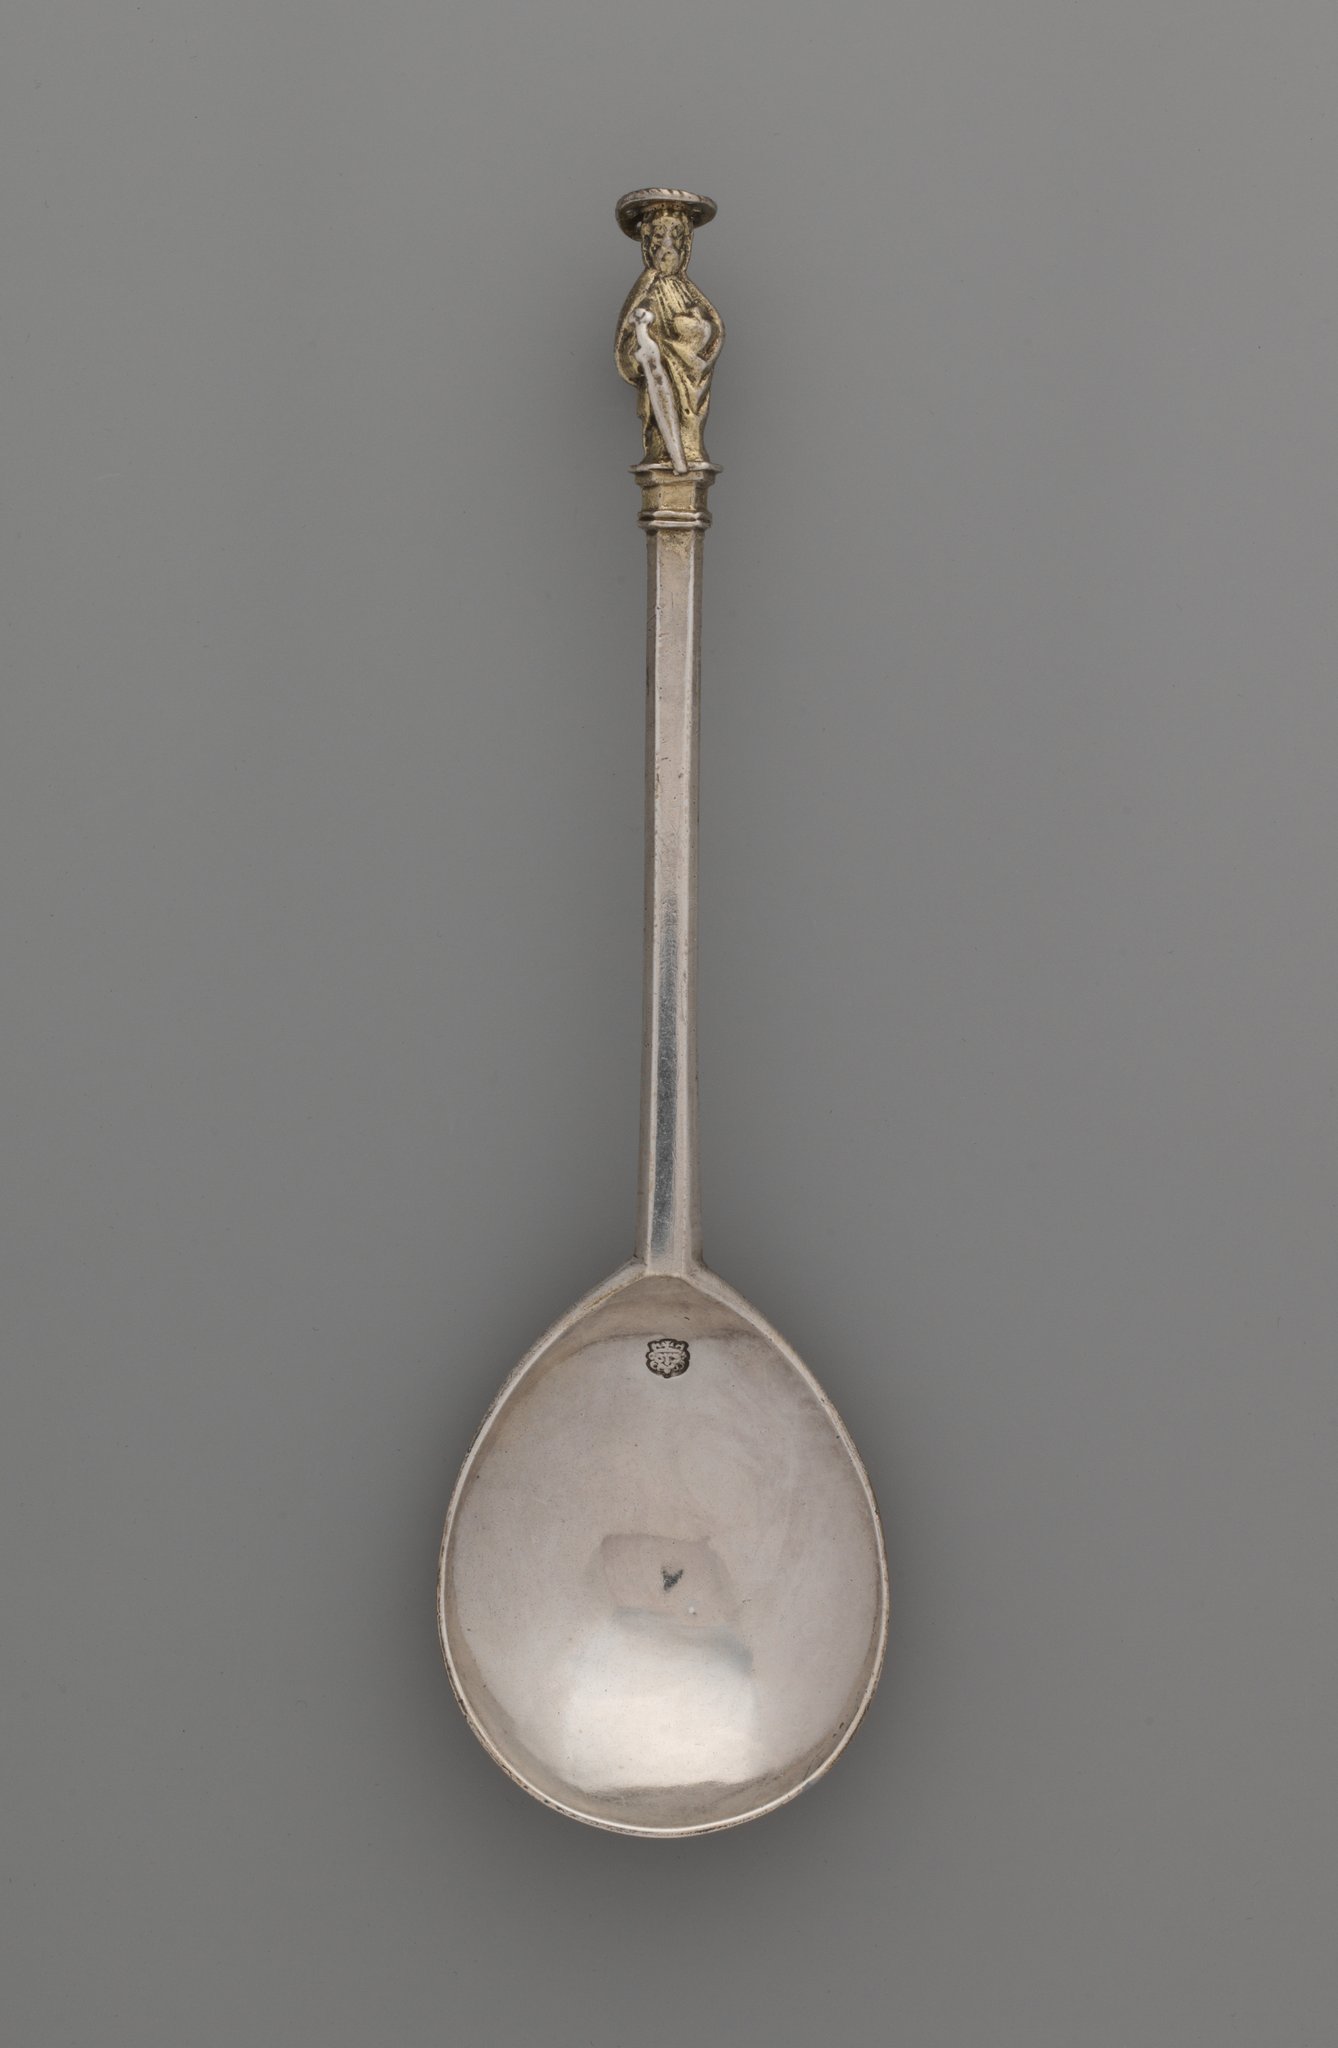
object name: apostle spoon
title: Apostle spoon: St. Bartholomew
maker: william cawdell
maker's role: maker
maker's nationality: british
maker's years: 1560-1625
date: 1592-1593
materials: silver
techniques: gilding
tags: saints